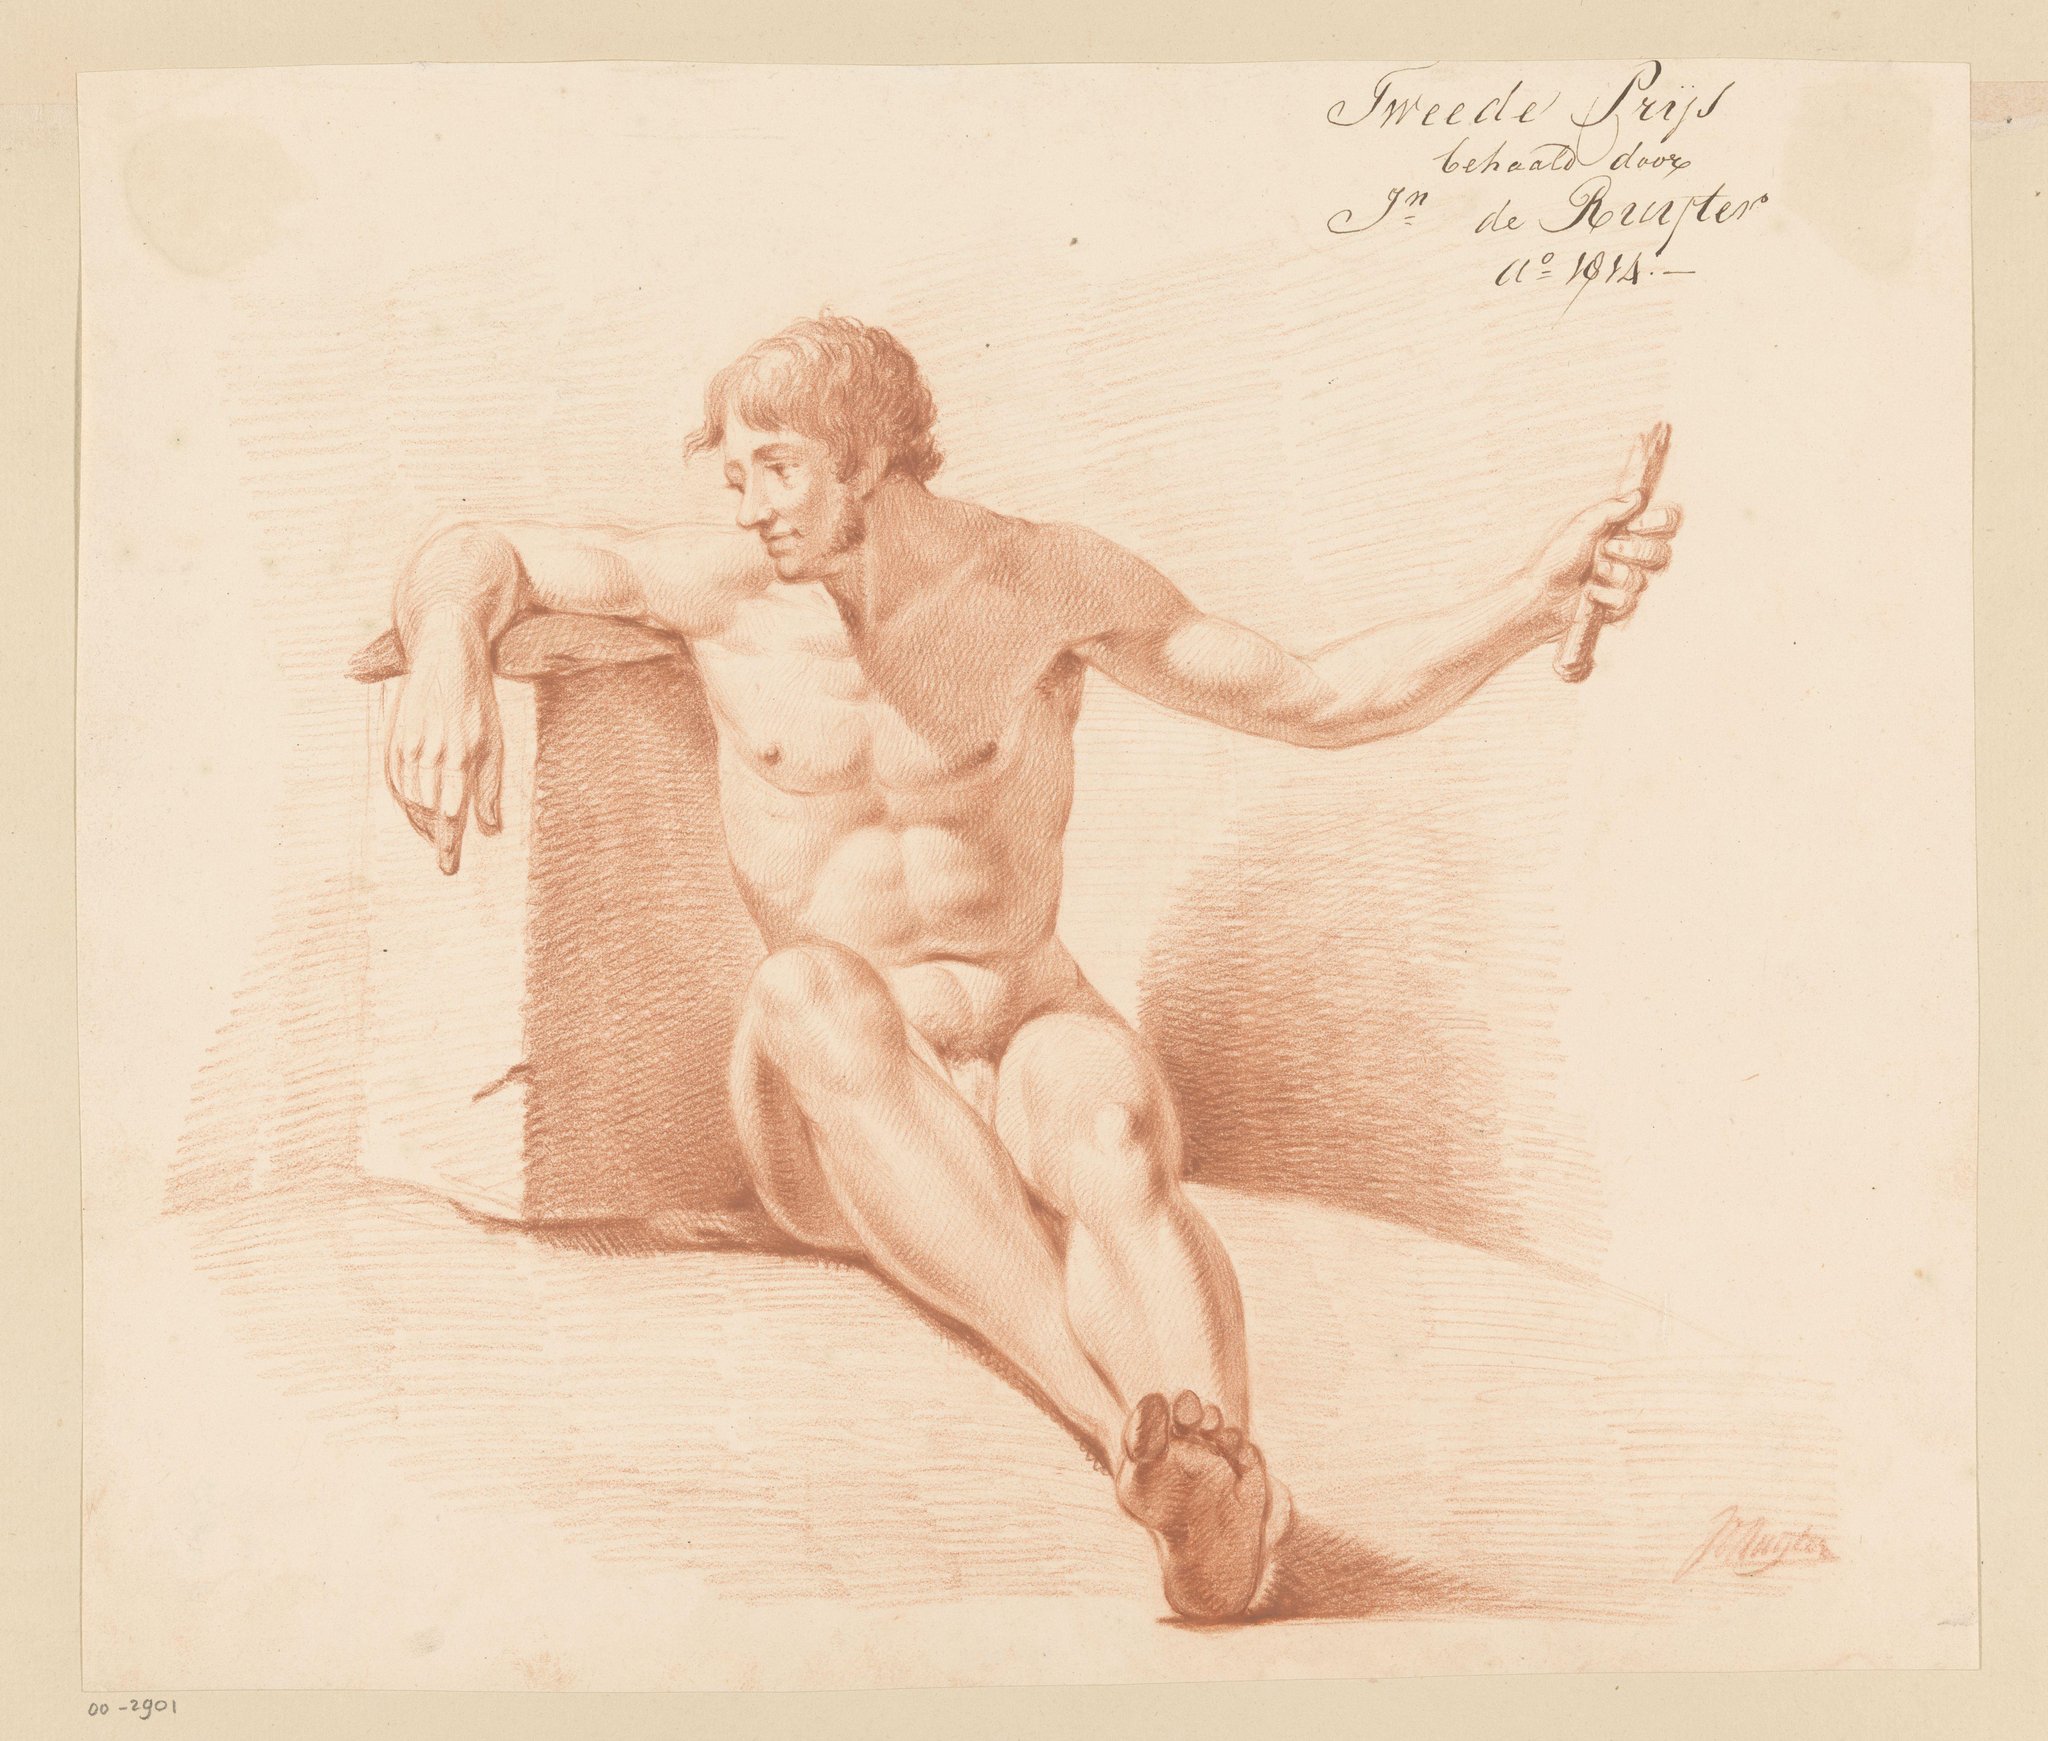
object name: drawing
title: Zittend mannelijk naakt, van voren gezien (2e prijs 1814)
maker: jan de ruyter (ii)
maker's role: draughtsman, painter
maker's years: 1786-1831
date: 1814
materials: chalk, paper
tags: sitting figure (+ nude human being)